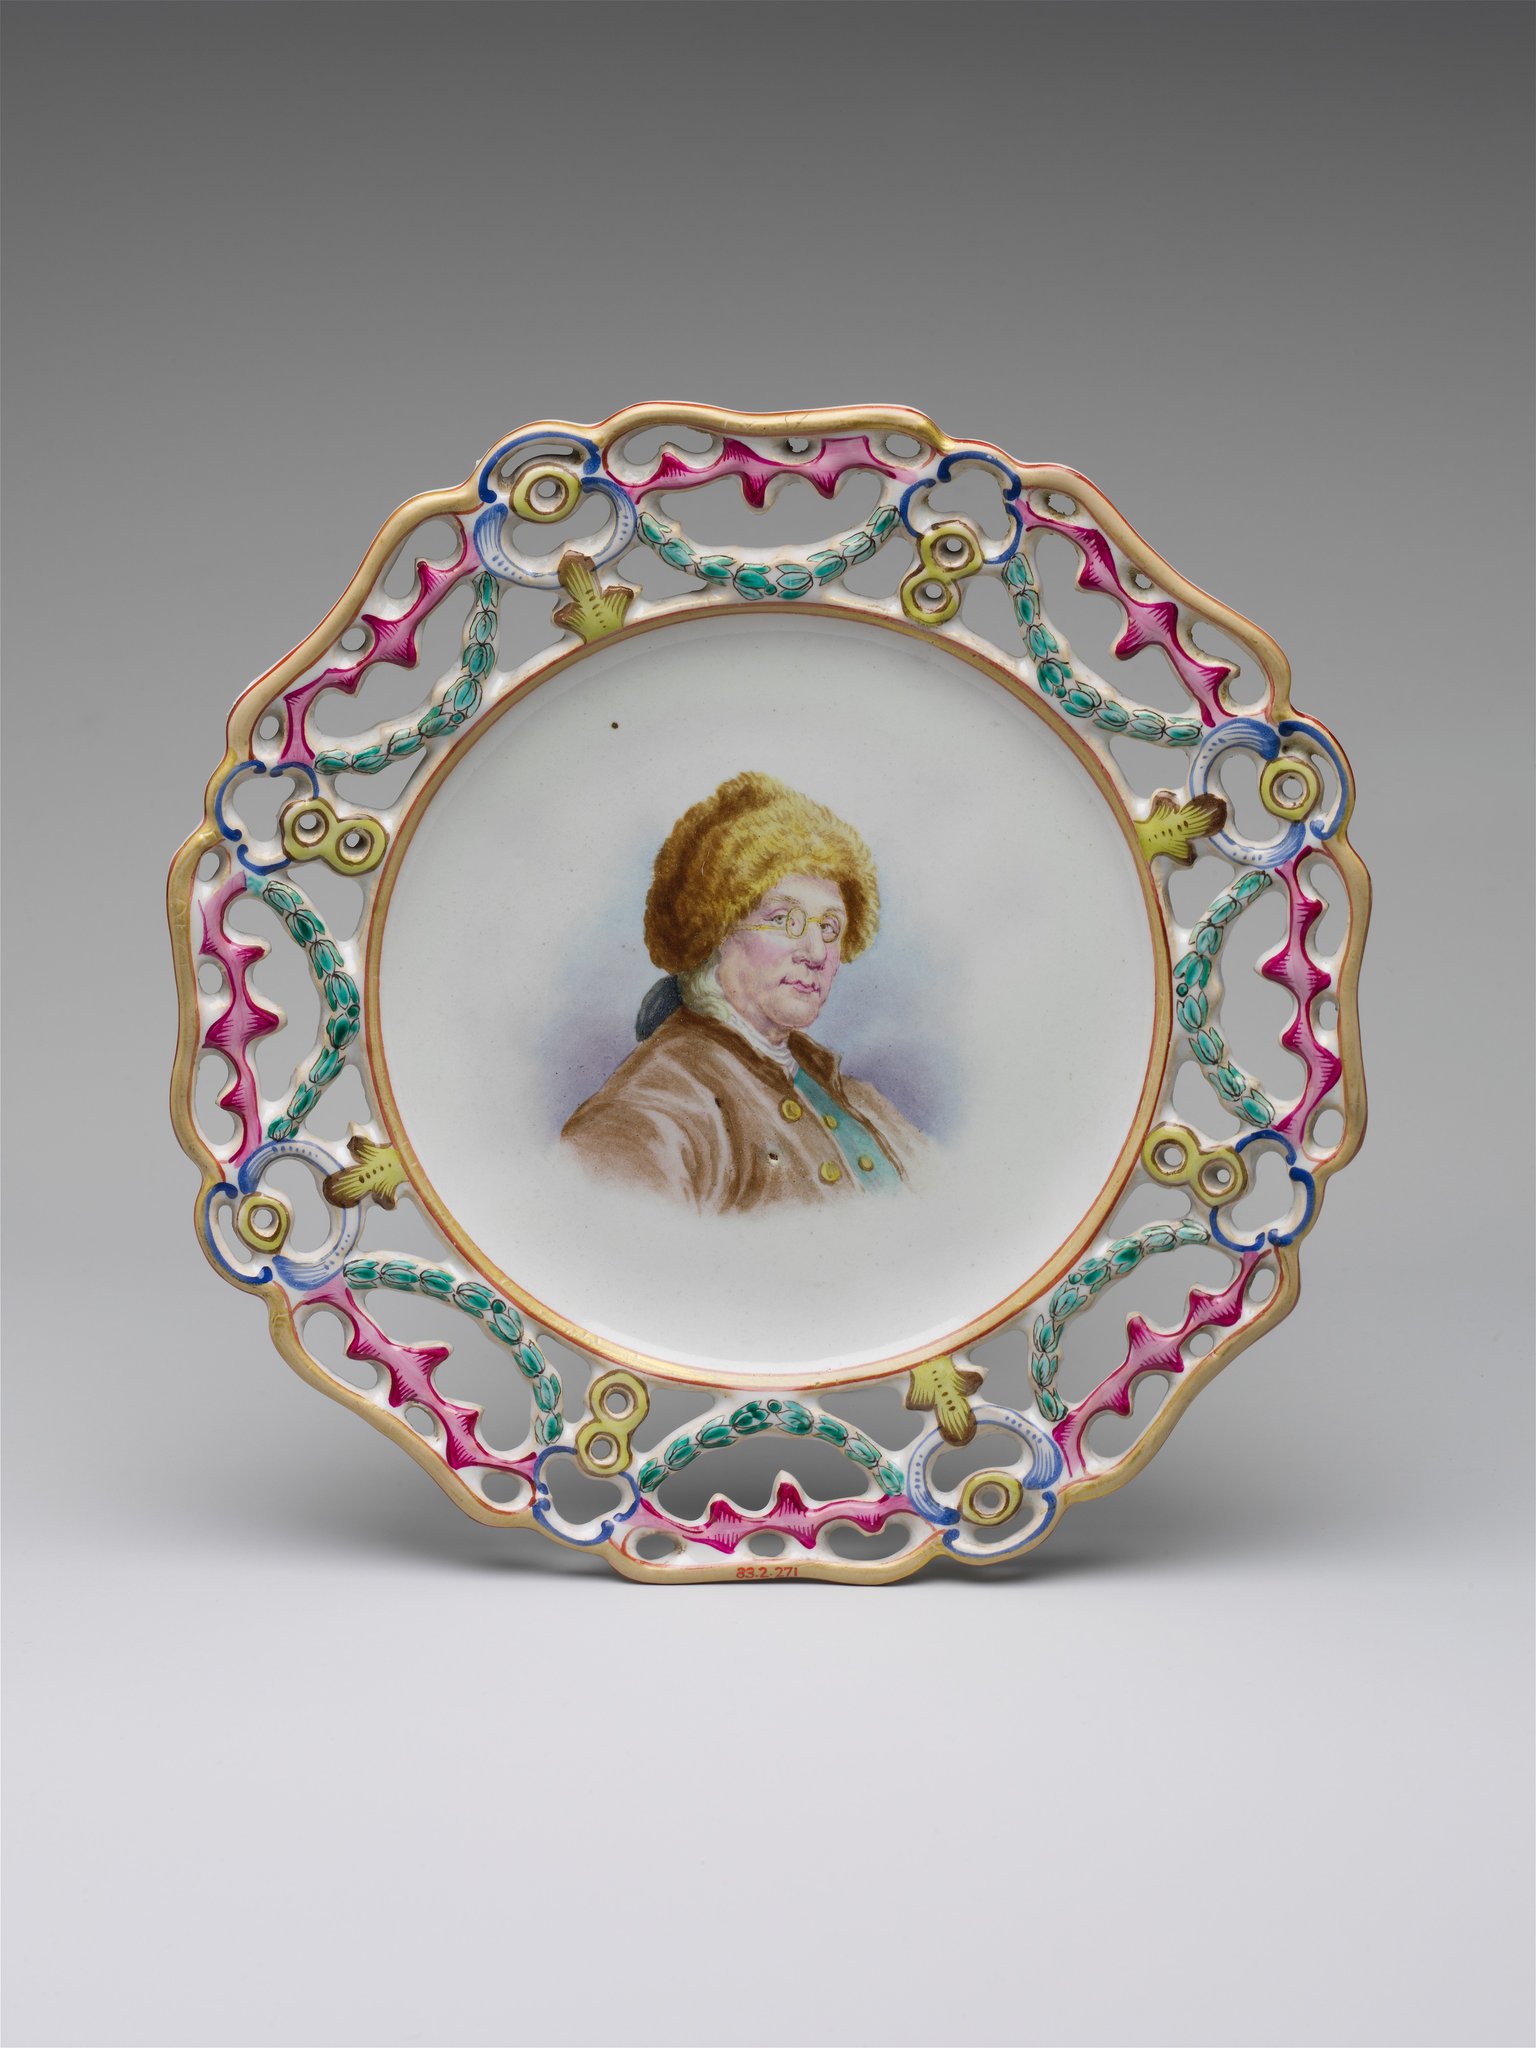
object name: plate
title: Benjamin Franklin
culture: french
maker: pierrette caudelot perrin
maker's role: maker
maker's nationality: french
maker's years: 1740-1793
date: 1770-1800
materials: faience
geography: france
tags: benjamin franklin,portraits